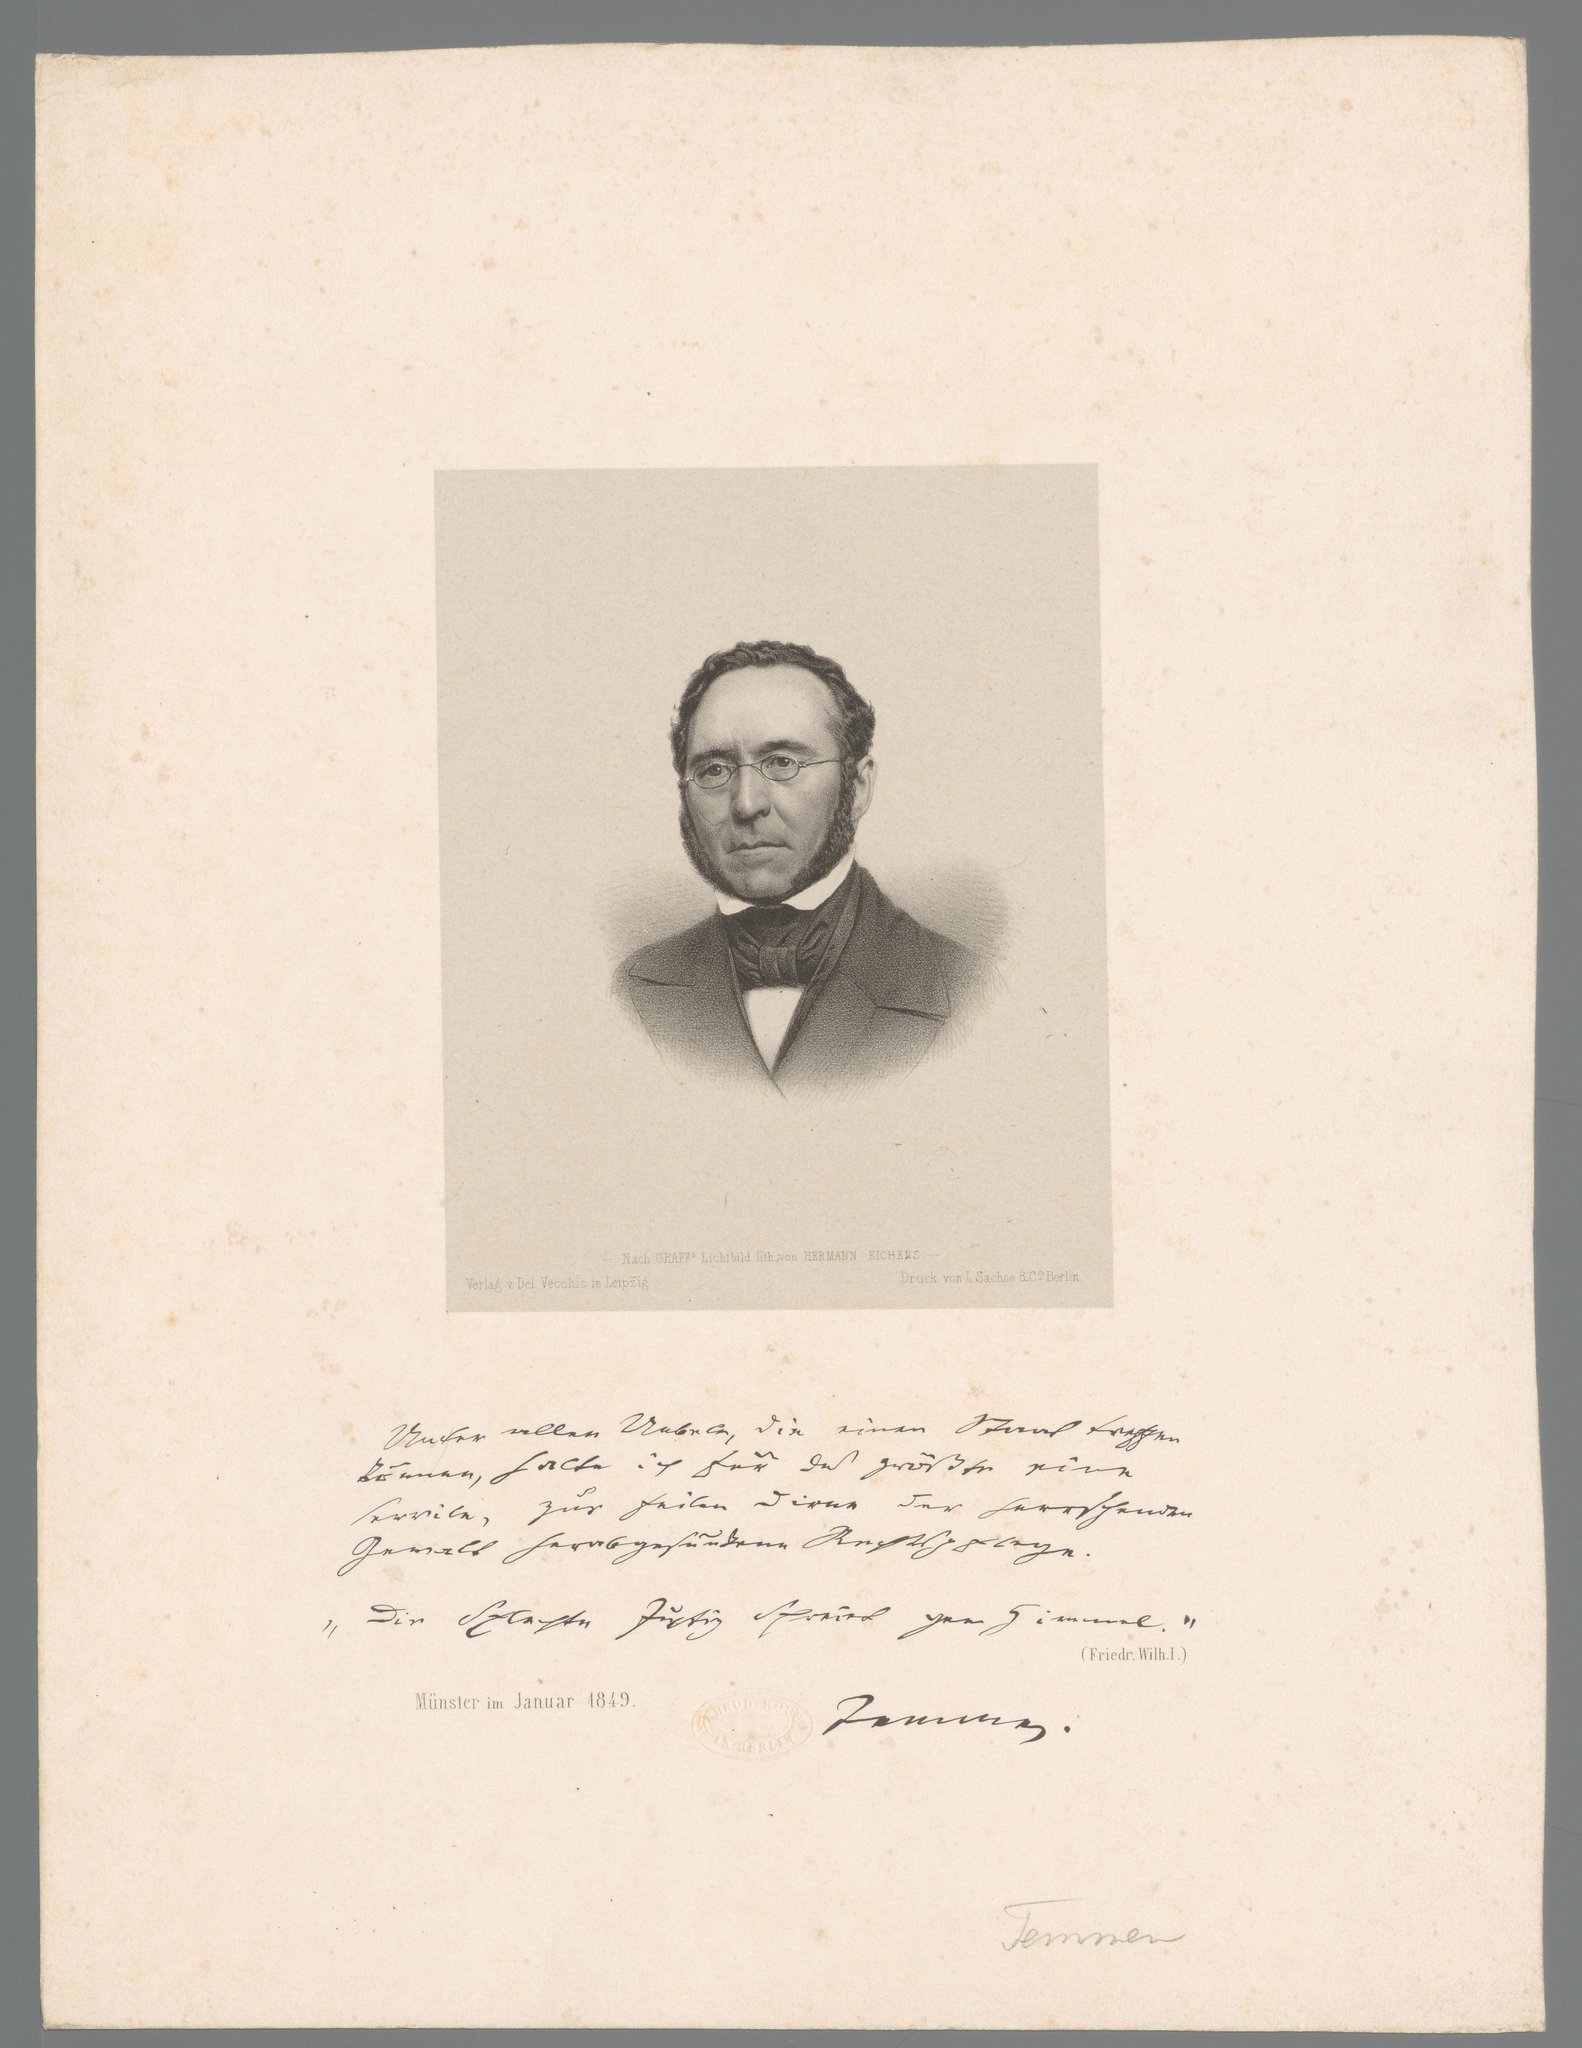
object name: print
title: Portret van een onbekende man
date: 1870-1886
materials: paper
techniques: lithograph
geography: berlin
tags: historical persons not known by name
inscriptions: collector's mark: Lugt 2228, check stamp: Lugt 2141c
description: Portret van een verder onbekende man, met handtekening in facsimile waarin wellicht de naam Temme te lezen is.